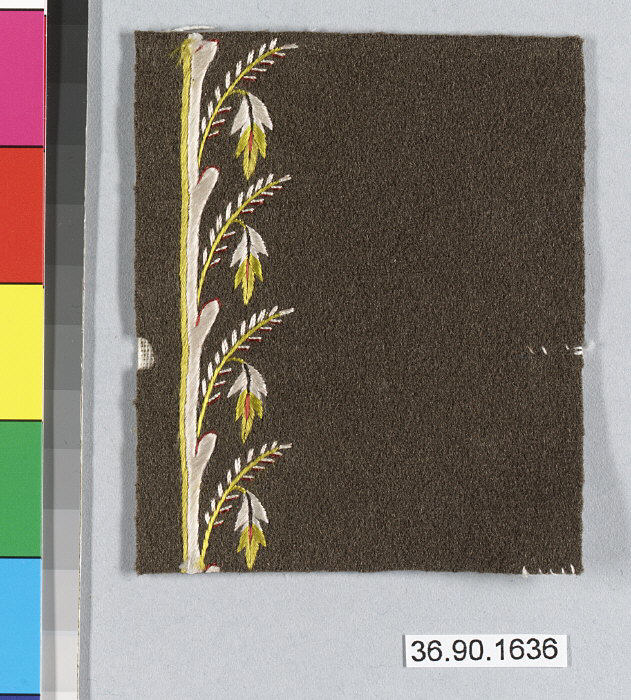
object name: sample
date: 1801-1833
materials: felt, silk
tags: plants